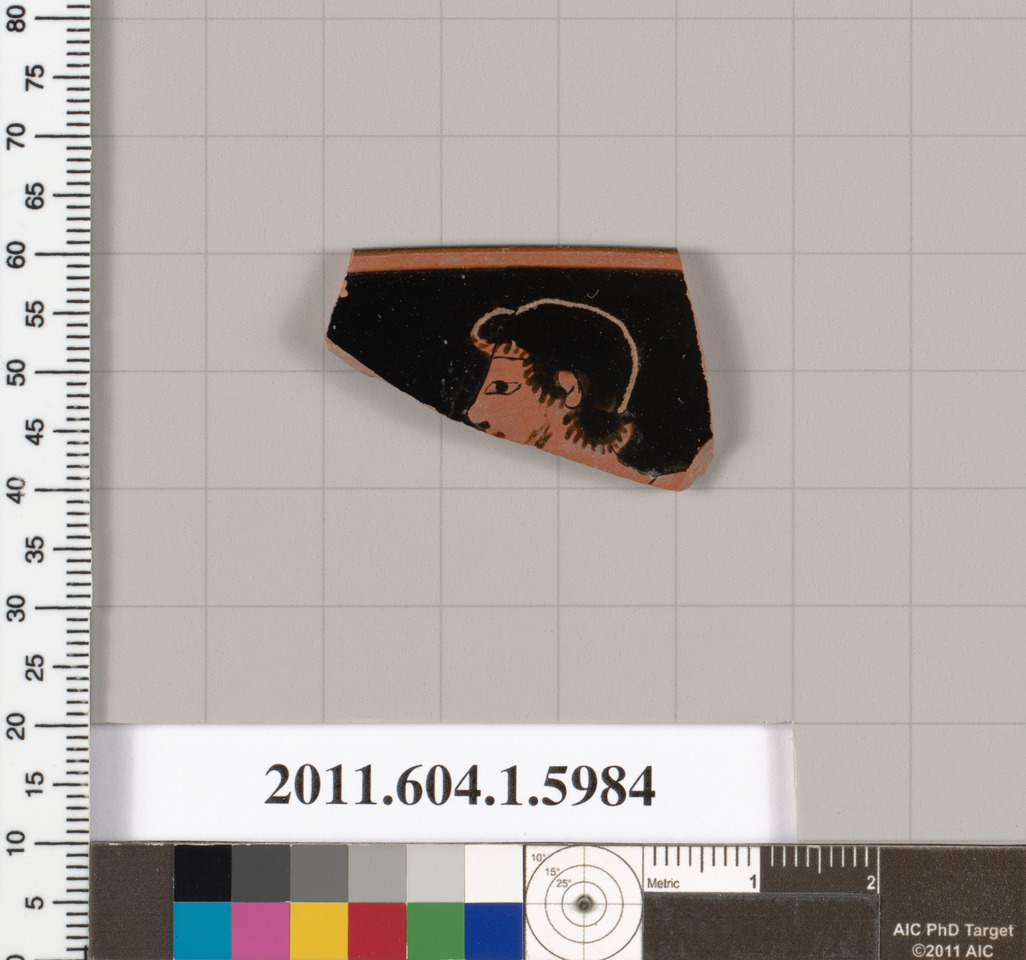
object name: kylix fragment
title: Terracotta rim fragment of a kylix (drinking cup)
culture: greek, attic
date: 510-500 BCE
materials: terracotta